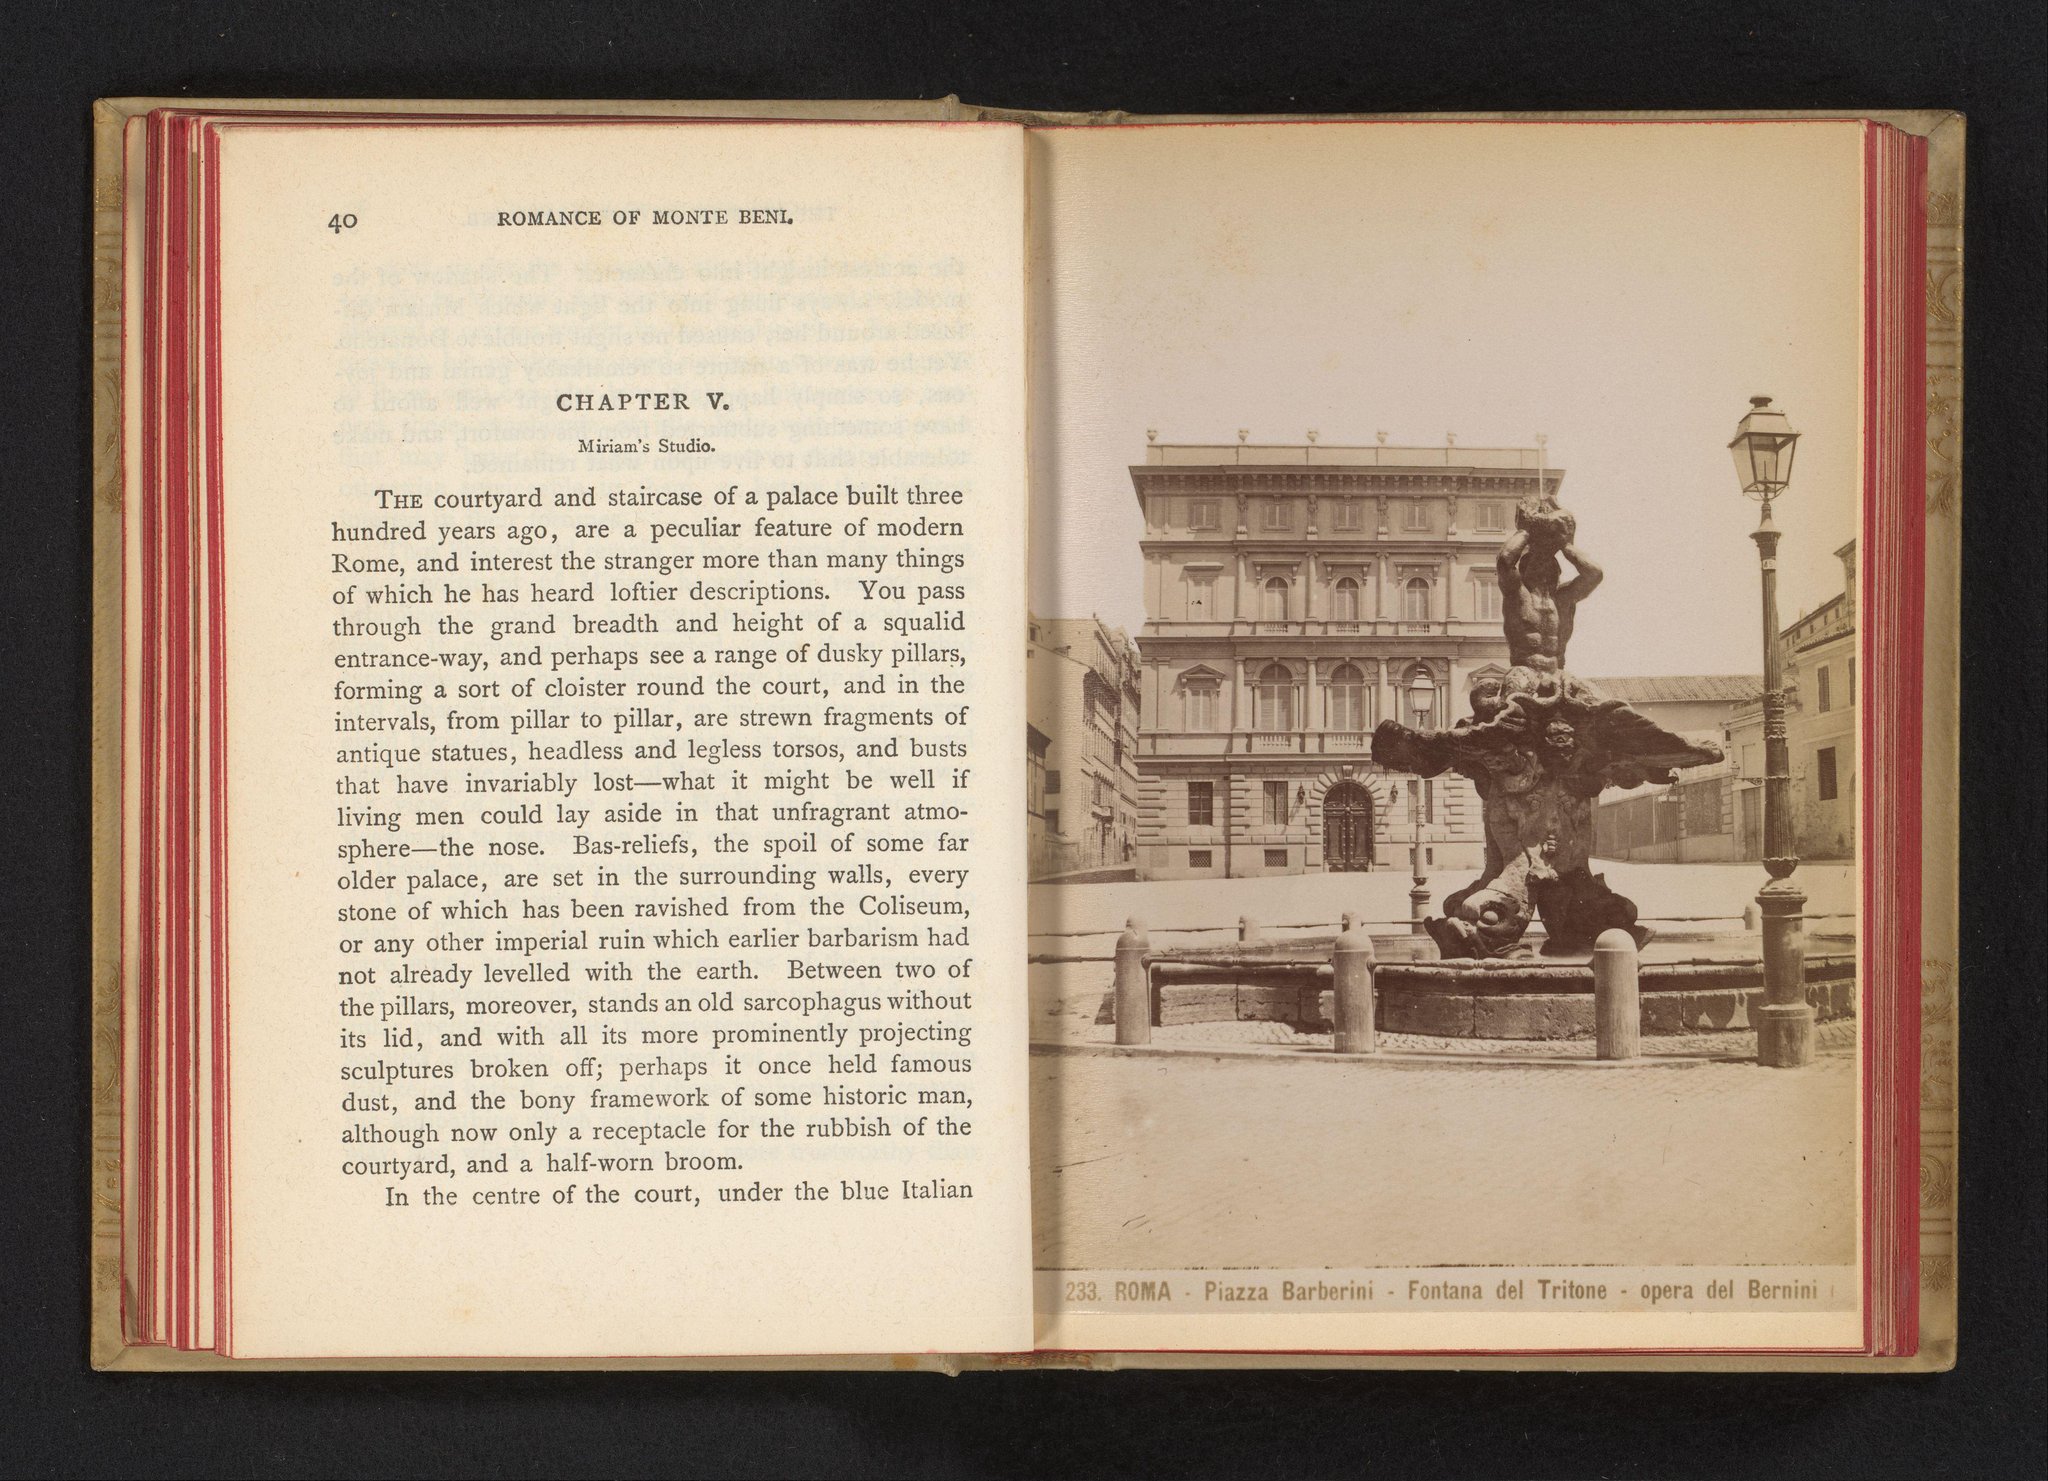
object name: photograph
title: Fontana del Tritone op het Piazza Barberini in Rome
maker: Anonymous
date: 1855-1860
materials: paper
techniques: albumen print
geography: piazza barberini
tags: ornamental fountain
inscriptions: number: ‘233.’